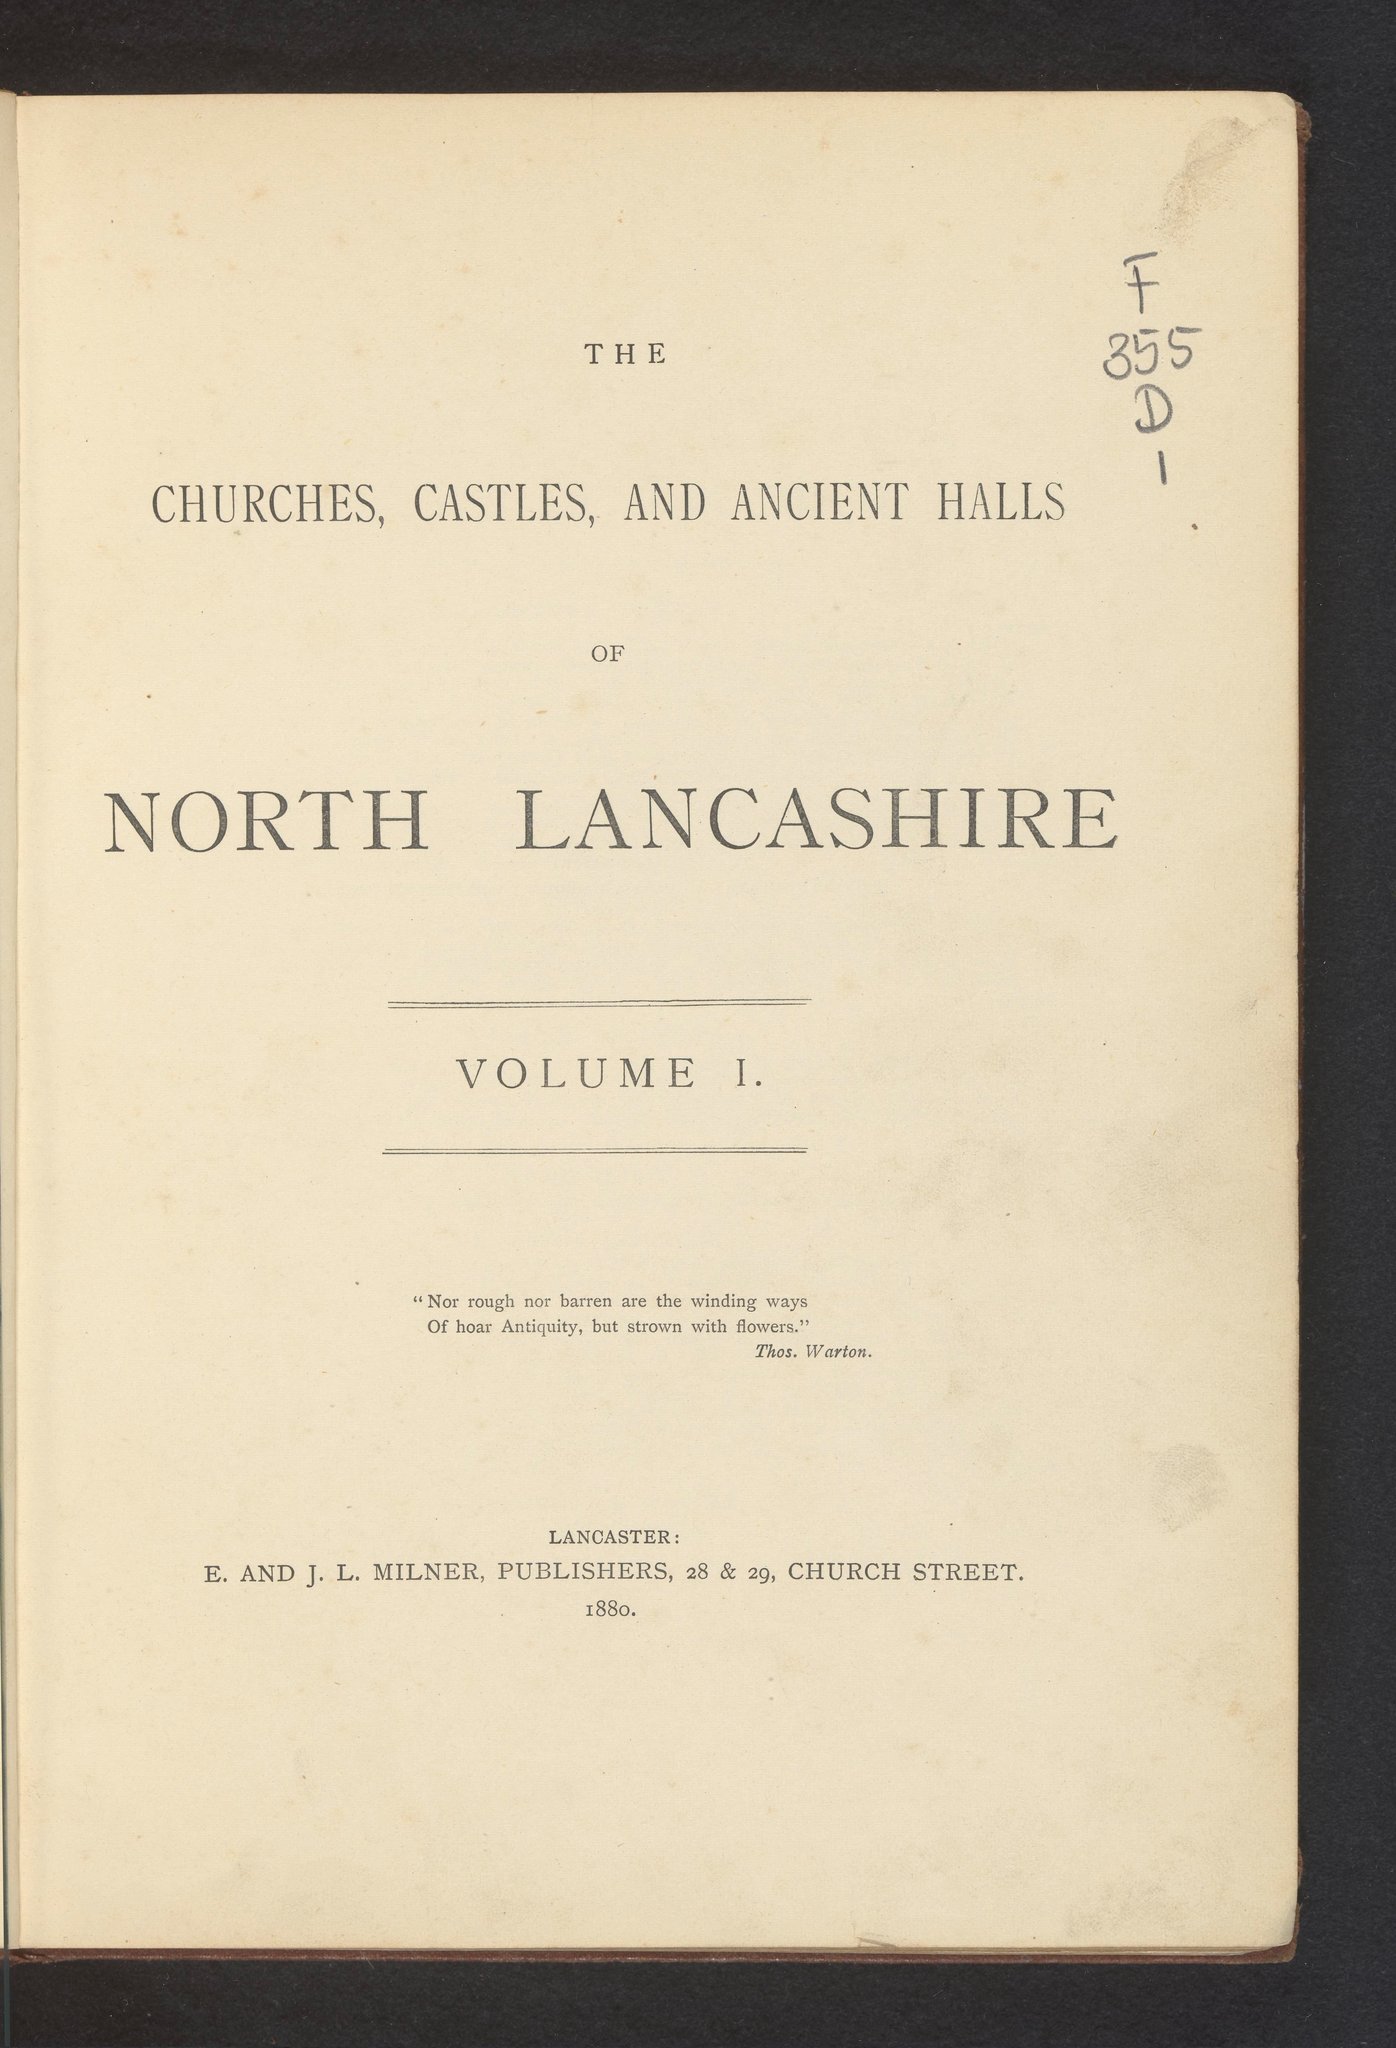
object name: book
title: The churches, castles, and ancient halls of North Lancashire, volume 1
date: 1880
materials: leather, paper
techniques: heliotype, photoaquatint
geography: lancaster